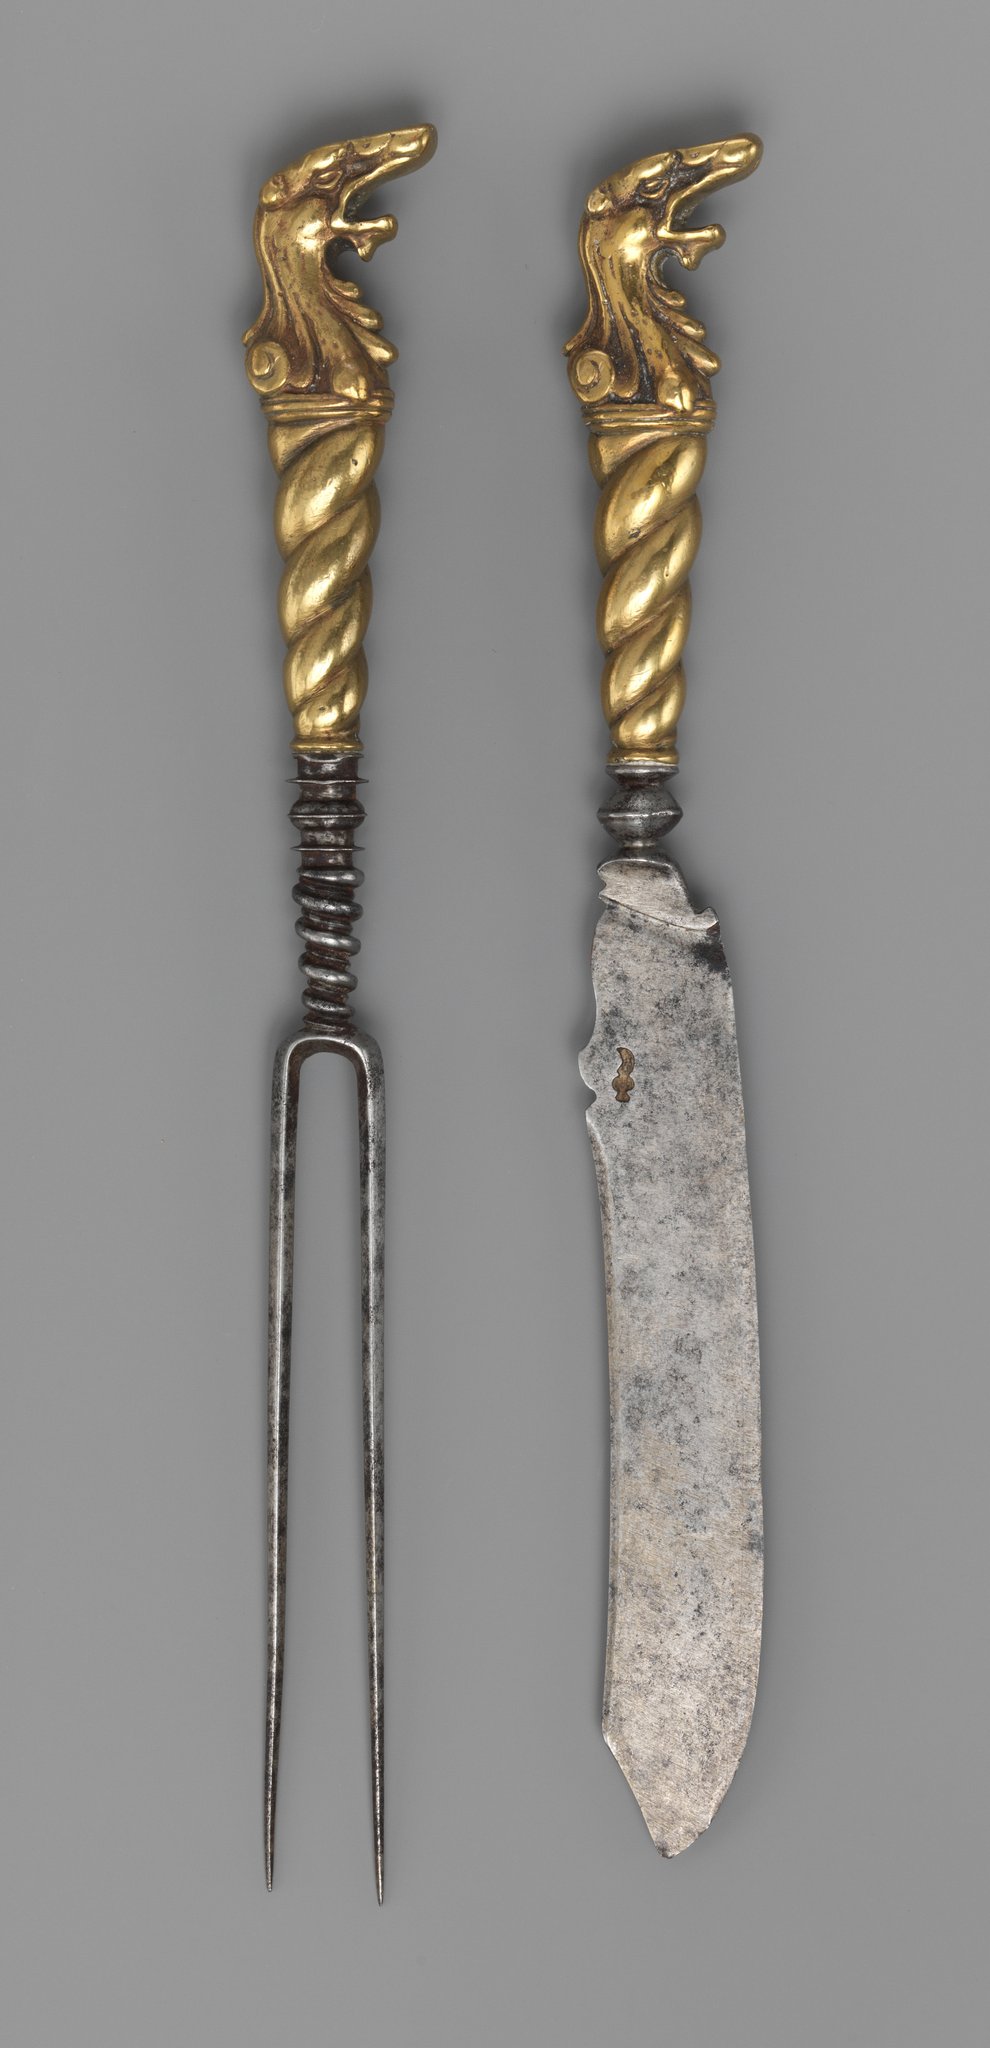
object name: table fork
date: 1601-1700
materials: brass, steel